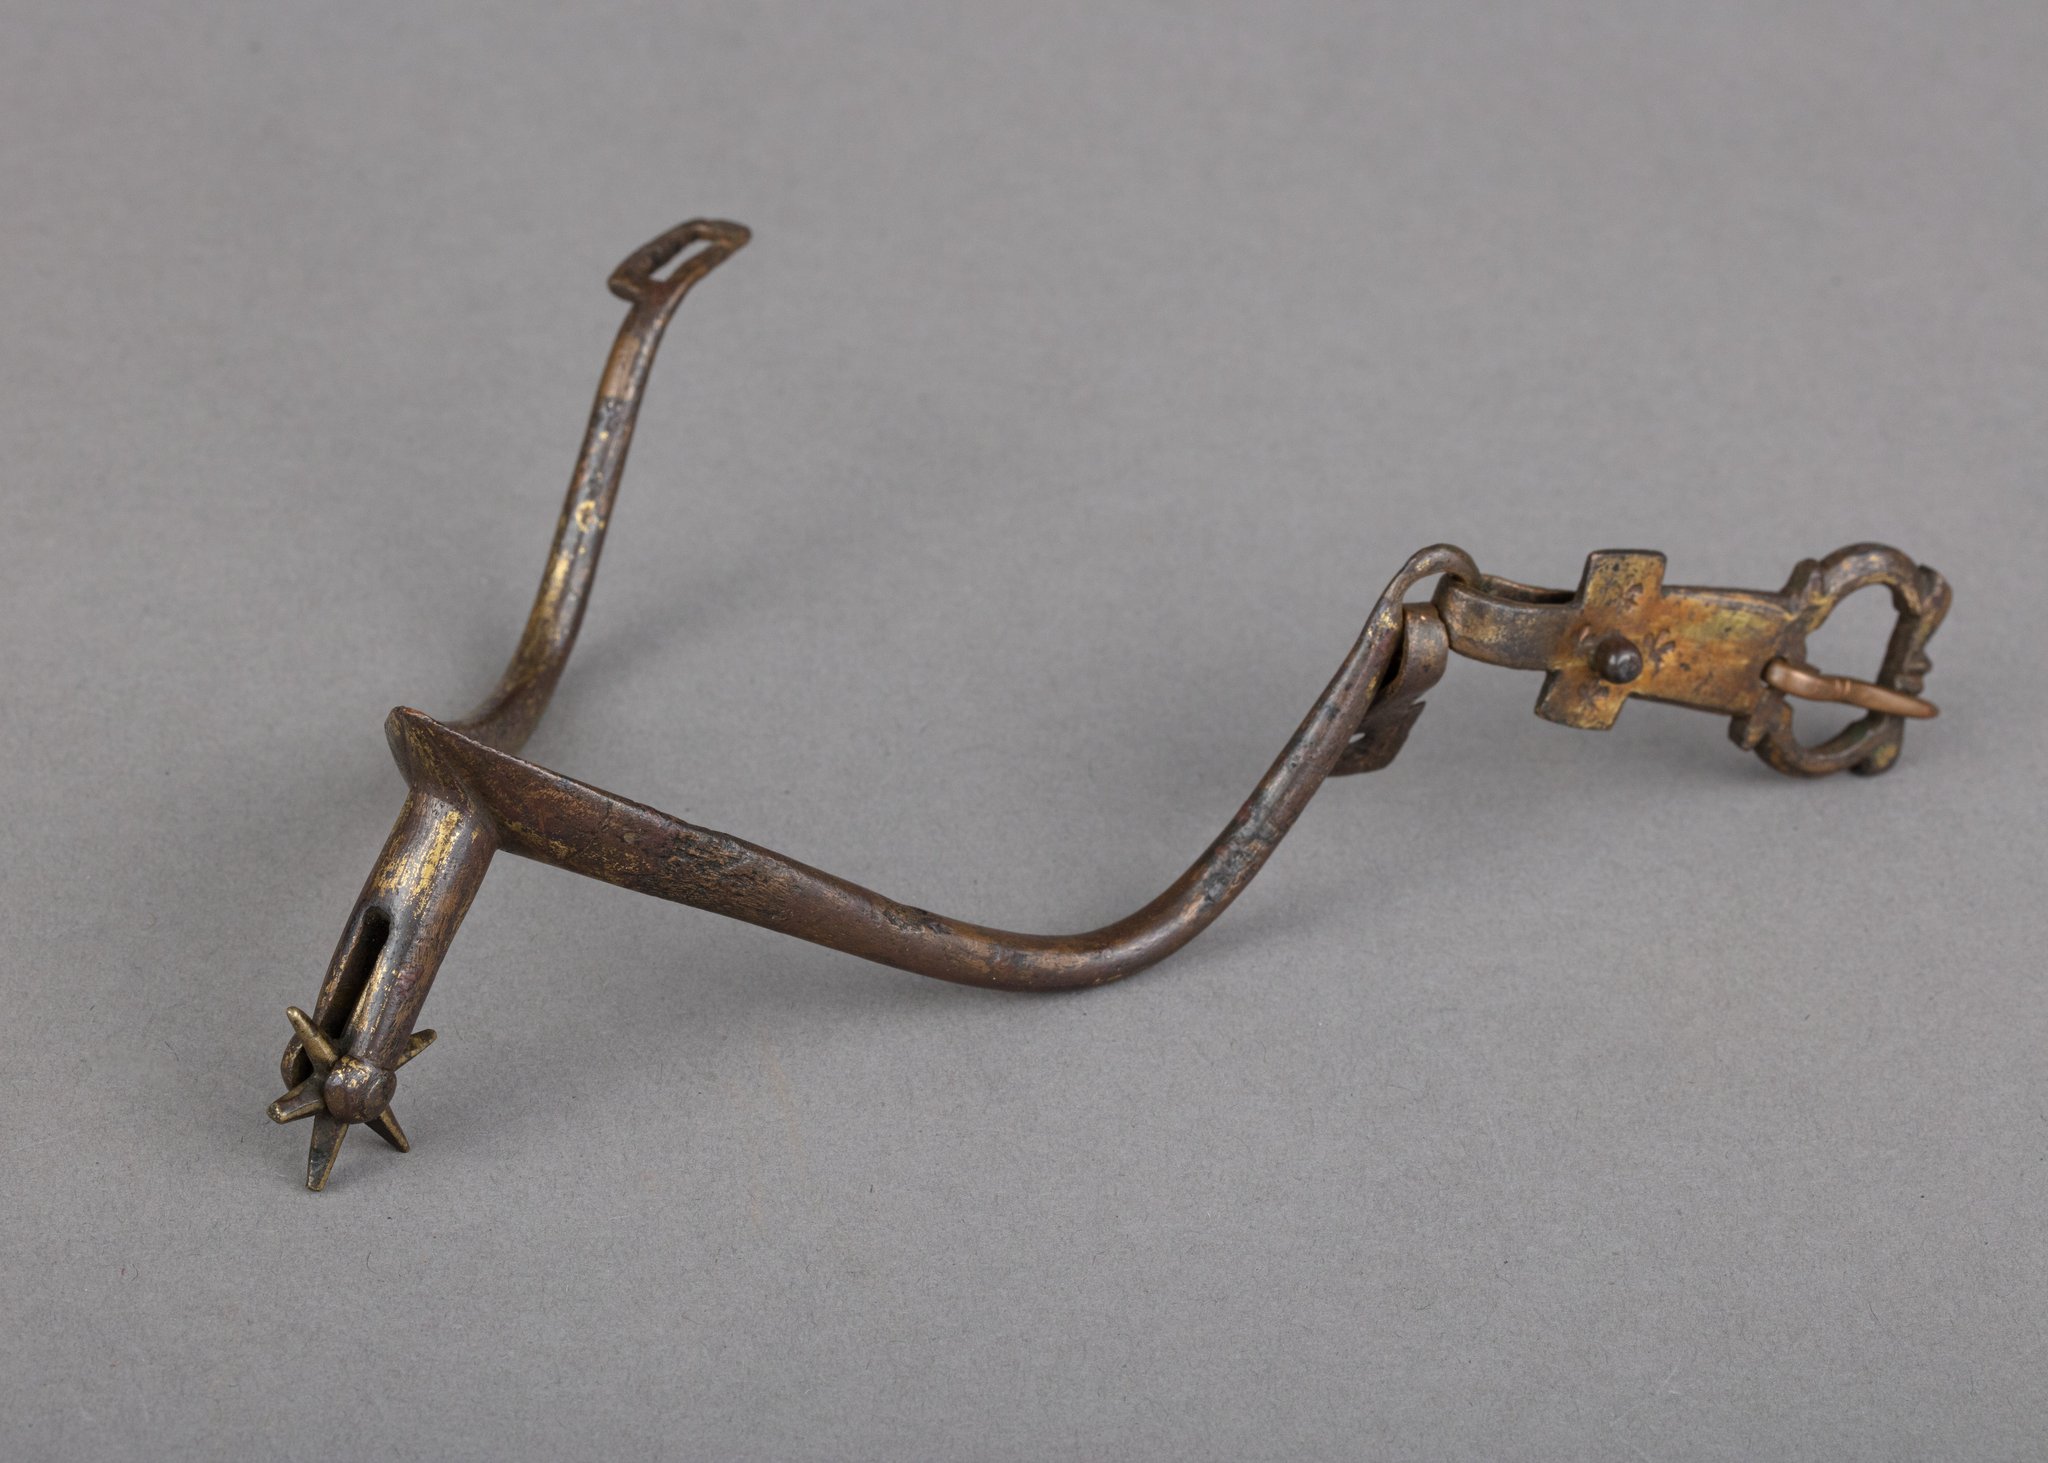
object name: spur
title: Rowel Spur (Right)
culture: french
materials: copper alloy, gold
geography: france